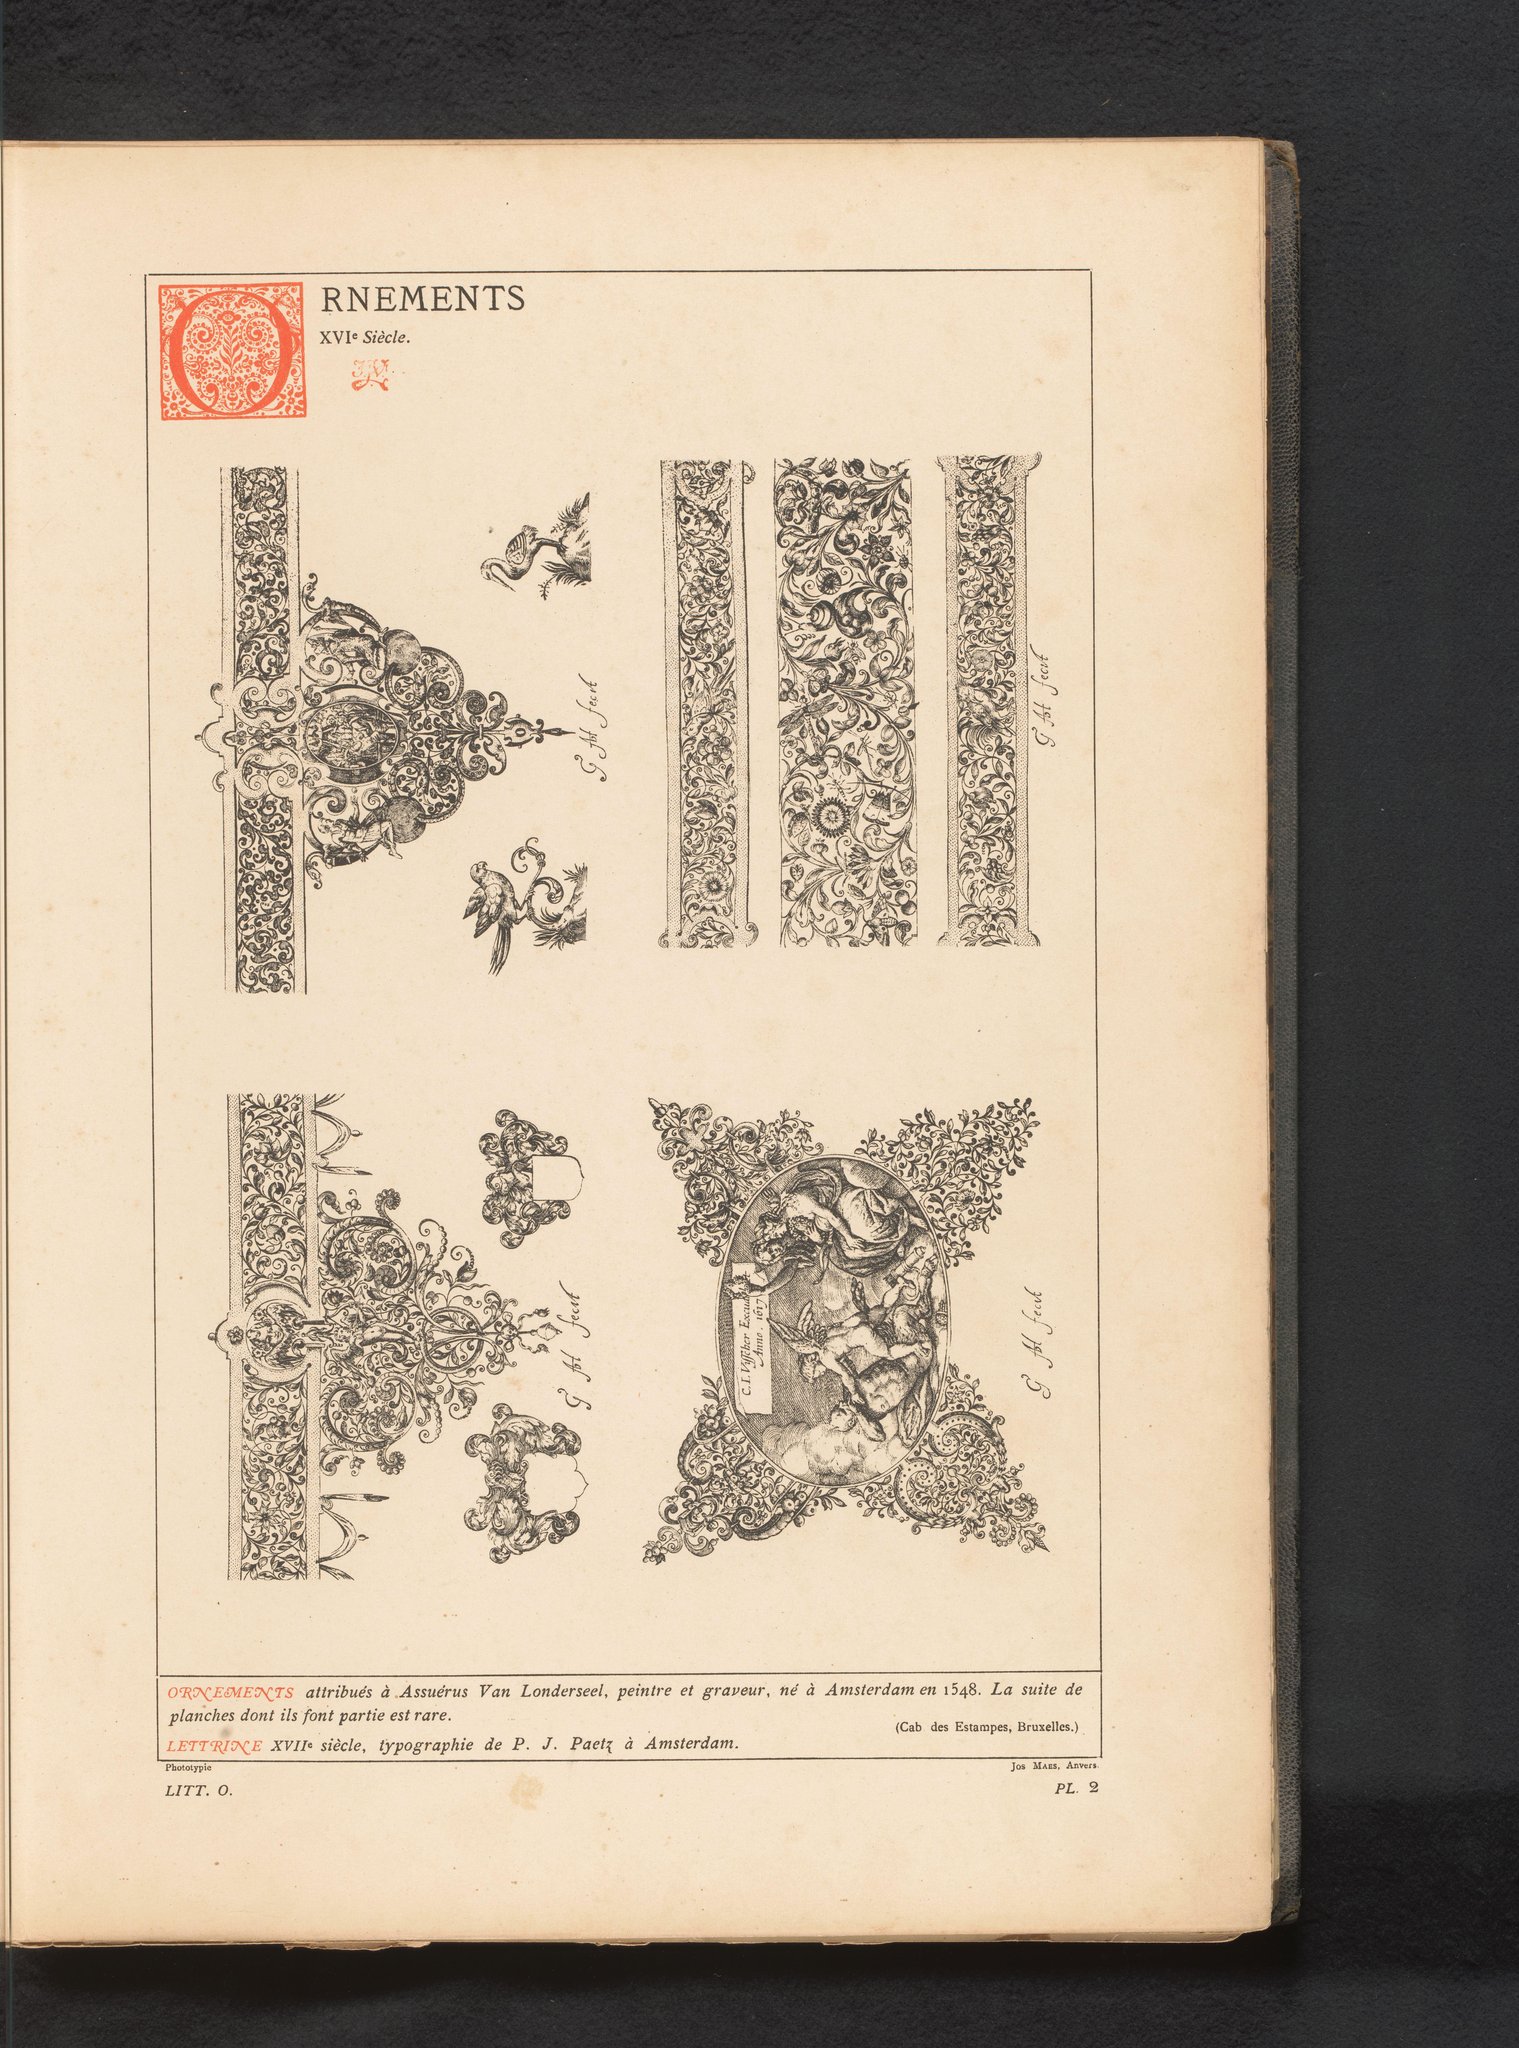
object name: page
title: Ornements, XVIe Siècle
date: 1876-1881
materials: paper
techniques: photolithography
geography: amsterdam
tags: ornaments ~ art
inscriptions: monogram: ‘JJvY’, inscription: ‘ORNEMENTS attribués à (...)’, inscription: ‘LITT. O. - PL. 2’